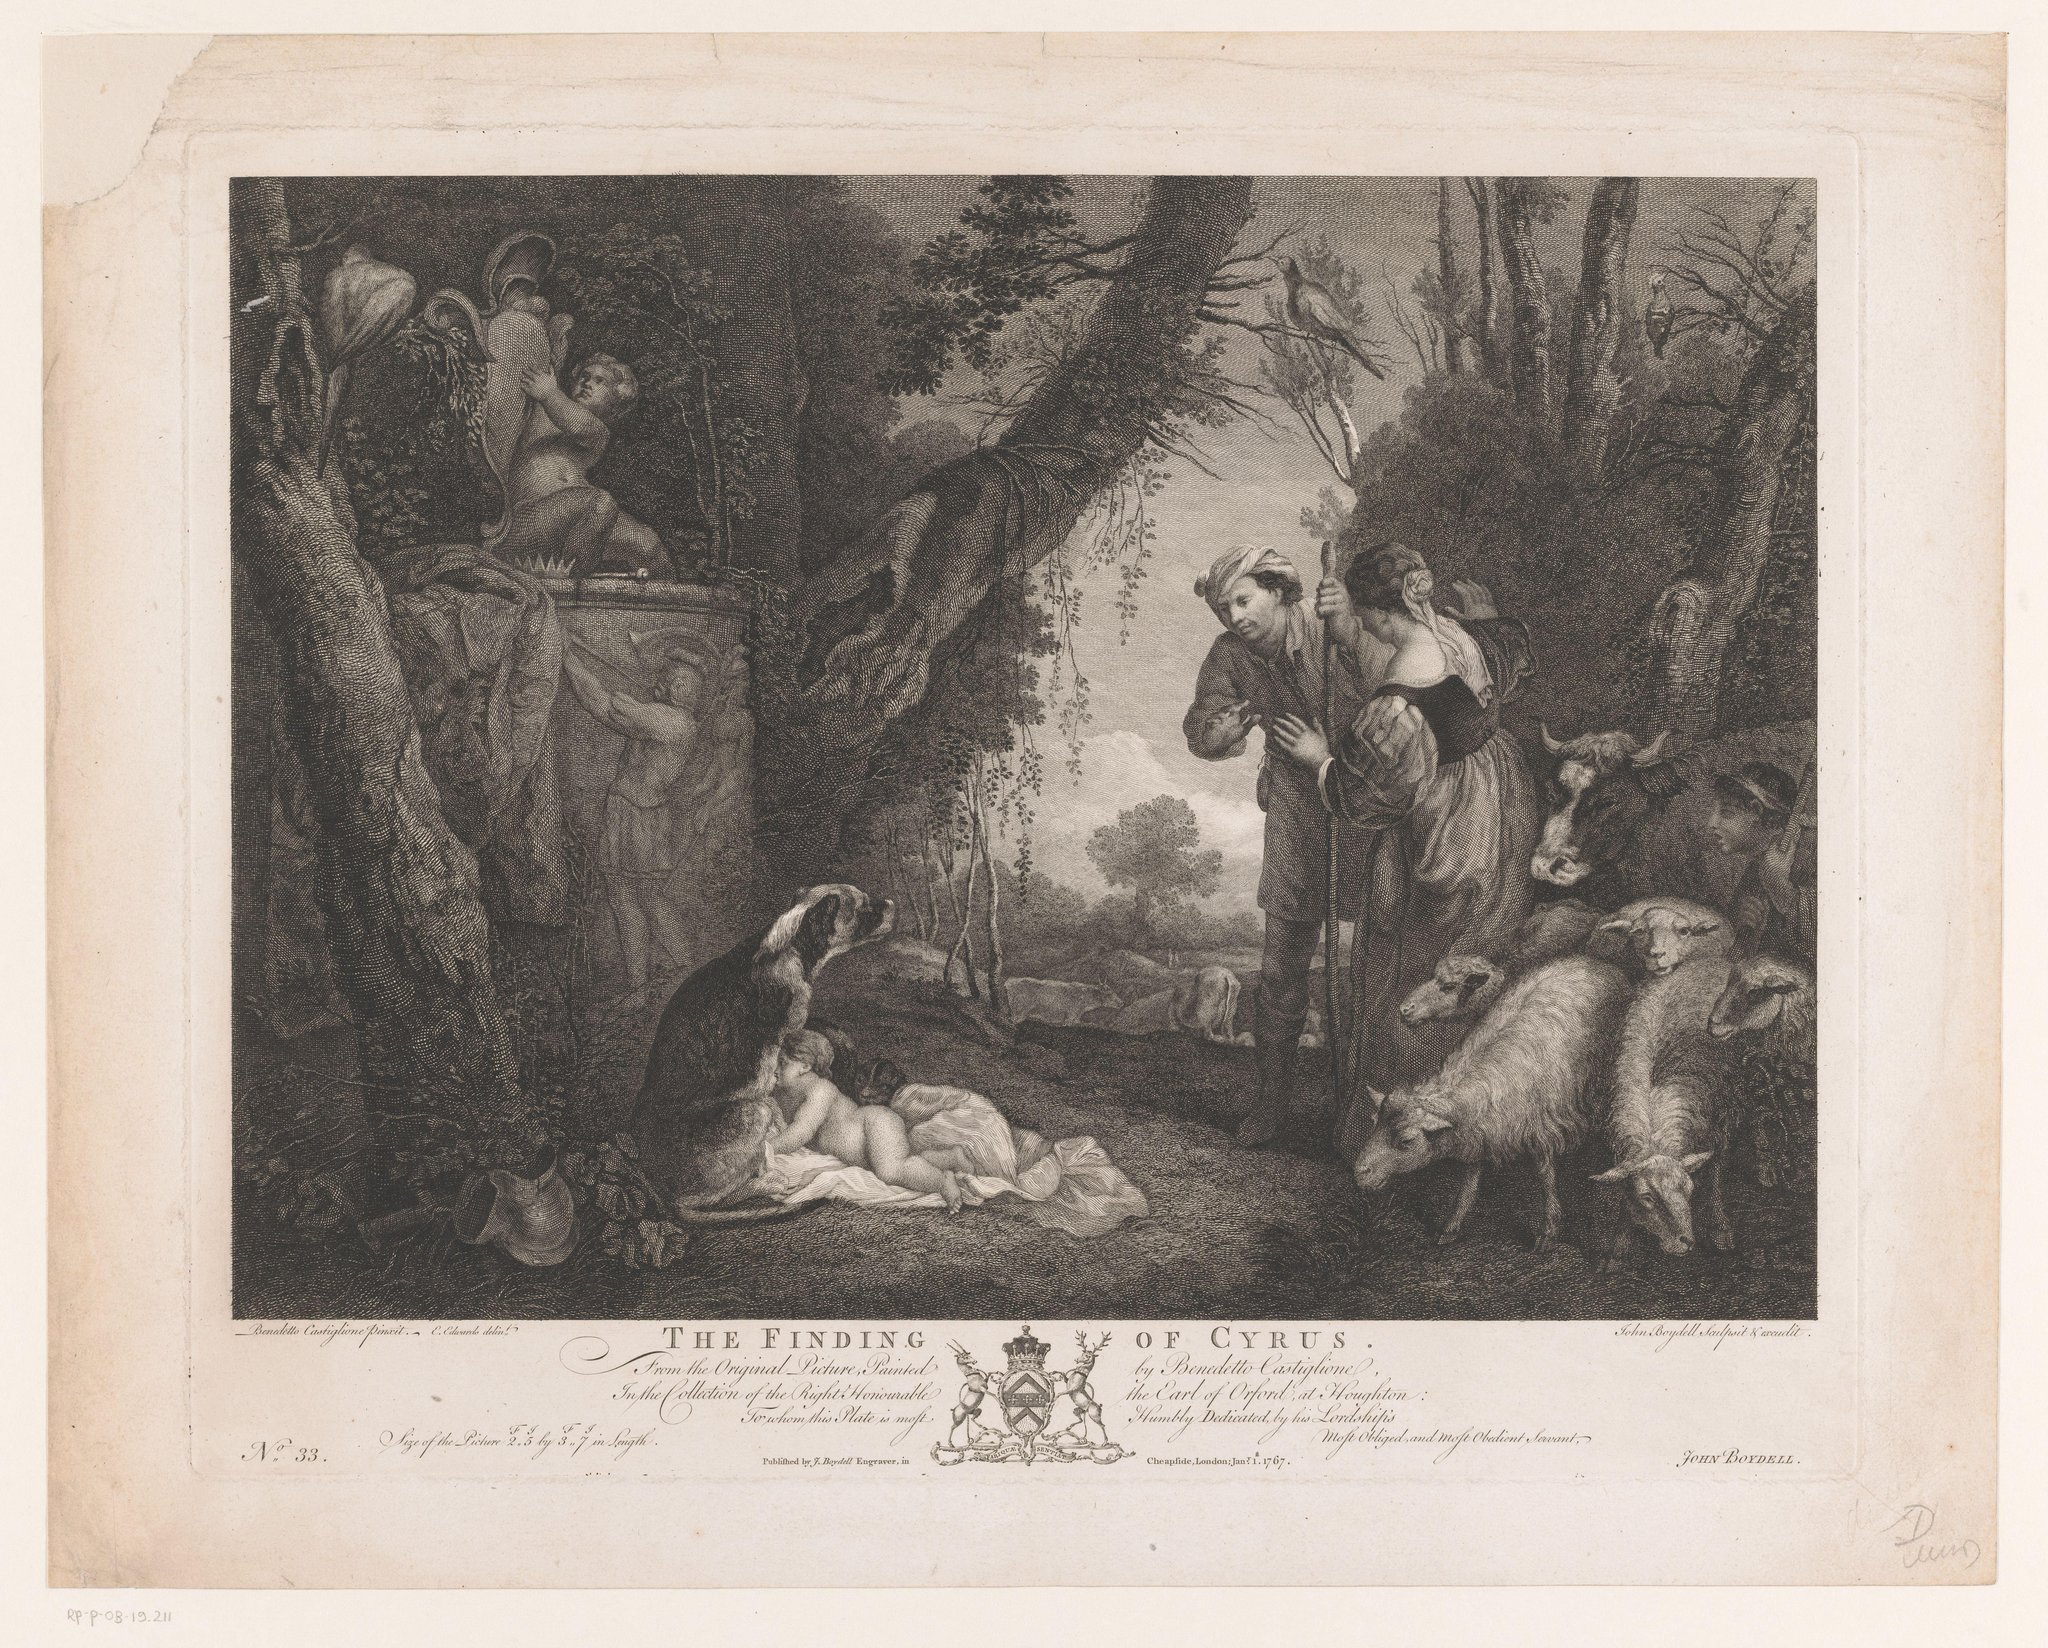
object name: print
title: Cyrus wordt gevonden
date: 1767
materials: paper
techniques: engraving, etching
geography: london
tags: the infant cyrus suckled by a bitch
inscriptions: collector's mark: Lugt 2228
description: Prent hoort bij de serie 'The Most Capital Paintings in England', tussen 1763 en 1786 gepubliceerd door John Boydell.